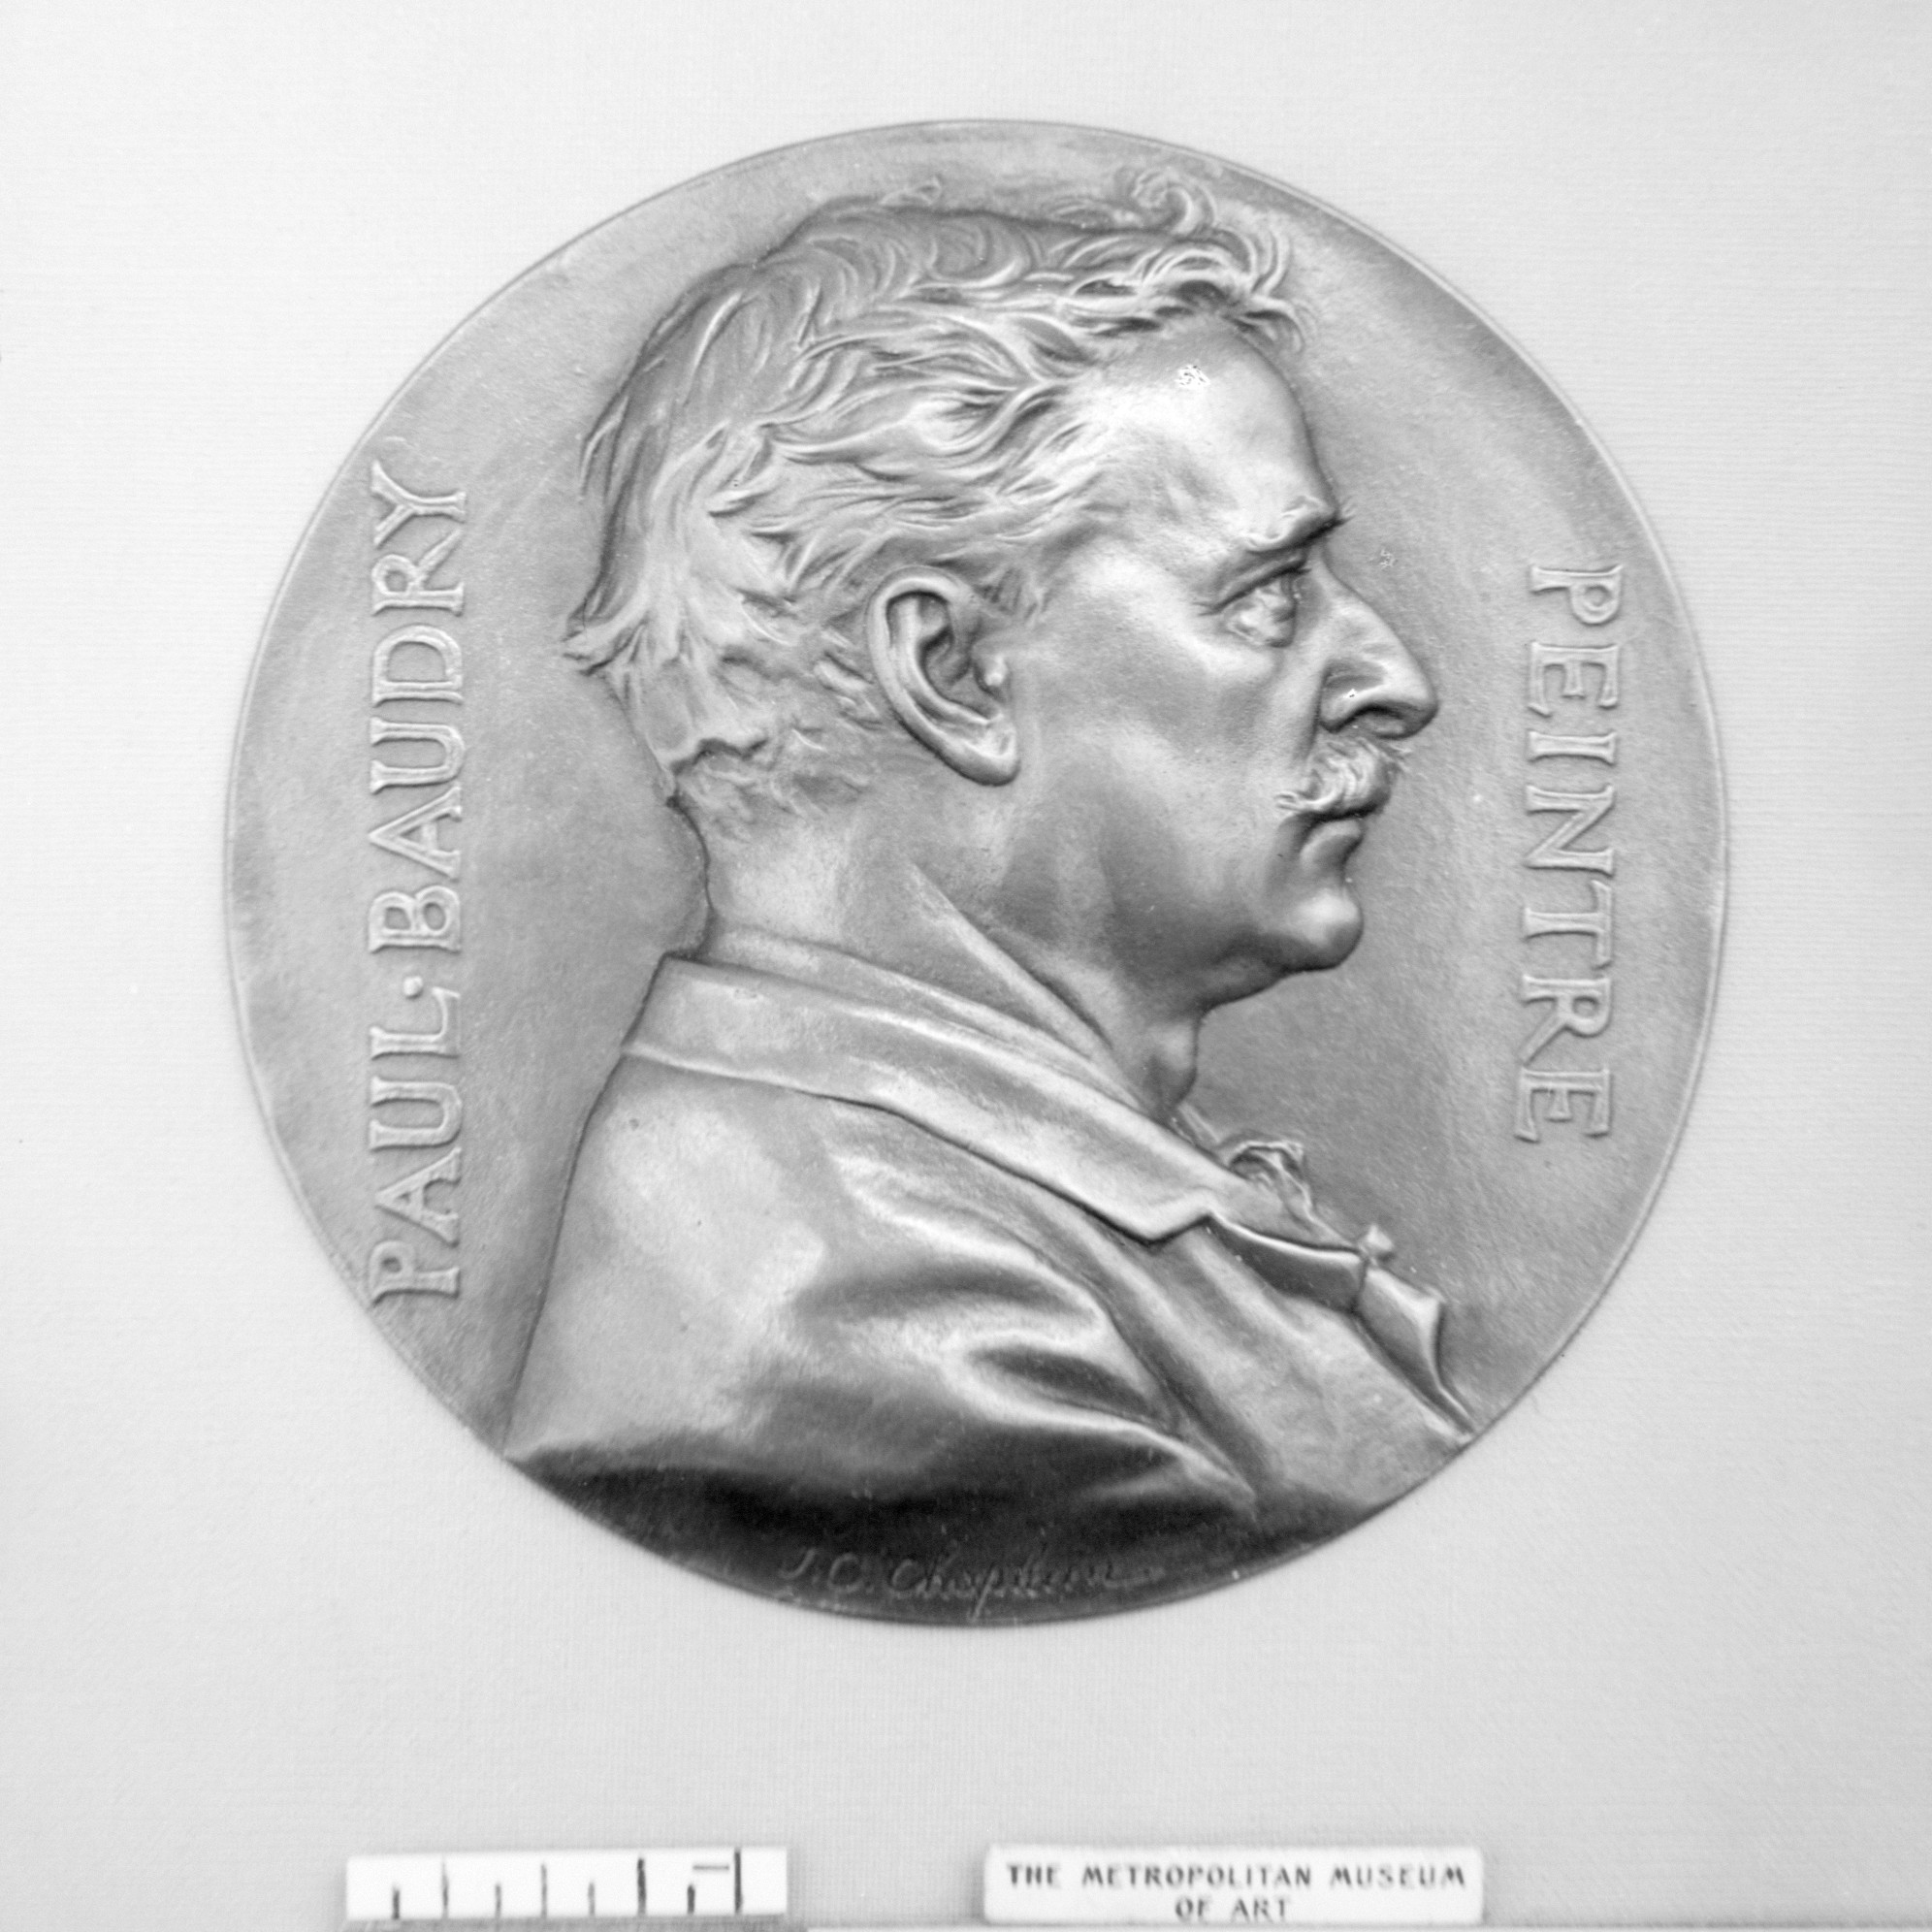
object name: medallion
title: Portrait of Baudry, the Painter (1828–1886)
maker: jules-clément chaplain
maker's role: artist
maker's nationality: french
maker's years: 1839-1909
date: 1801-1900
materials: bronze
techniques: casting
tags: men,profiles